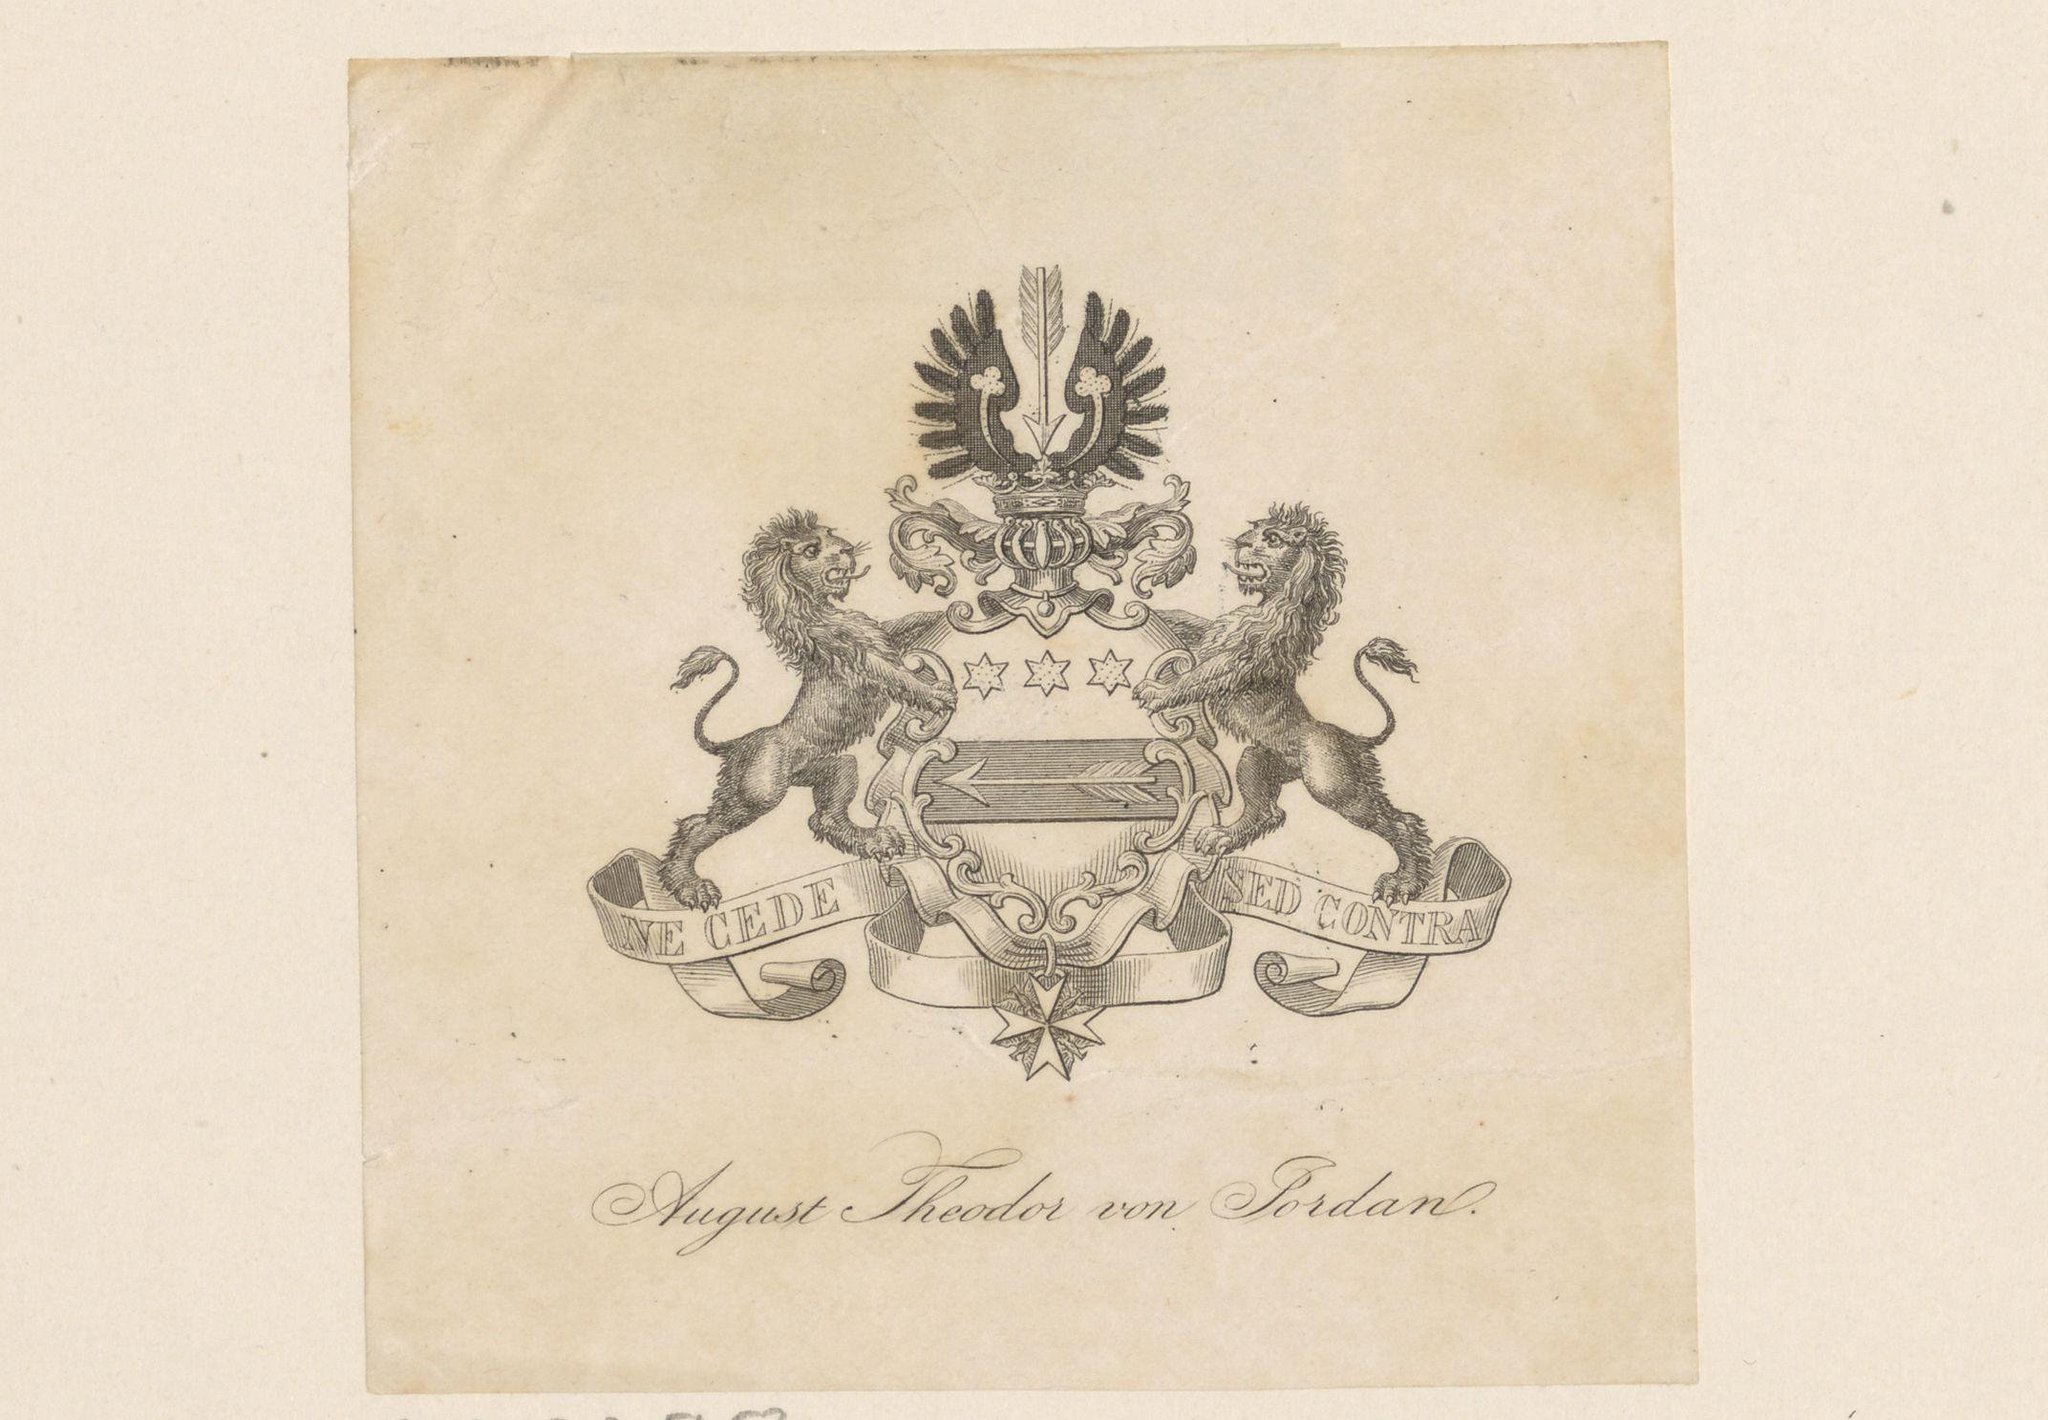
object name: bookplate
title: Ex libris van August Theodor von Jordan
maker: Anonymous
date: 1800-1899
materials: paper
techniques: etching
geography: germany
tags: archer's weapons: arrow, beasts of prey, predatory animals: lion, armorial bearing, heraldry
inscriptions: inscription: ‘Rietstap, 1, 1049.’